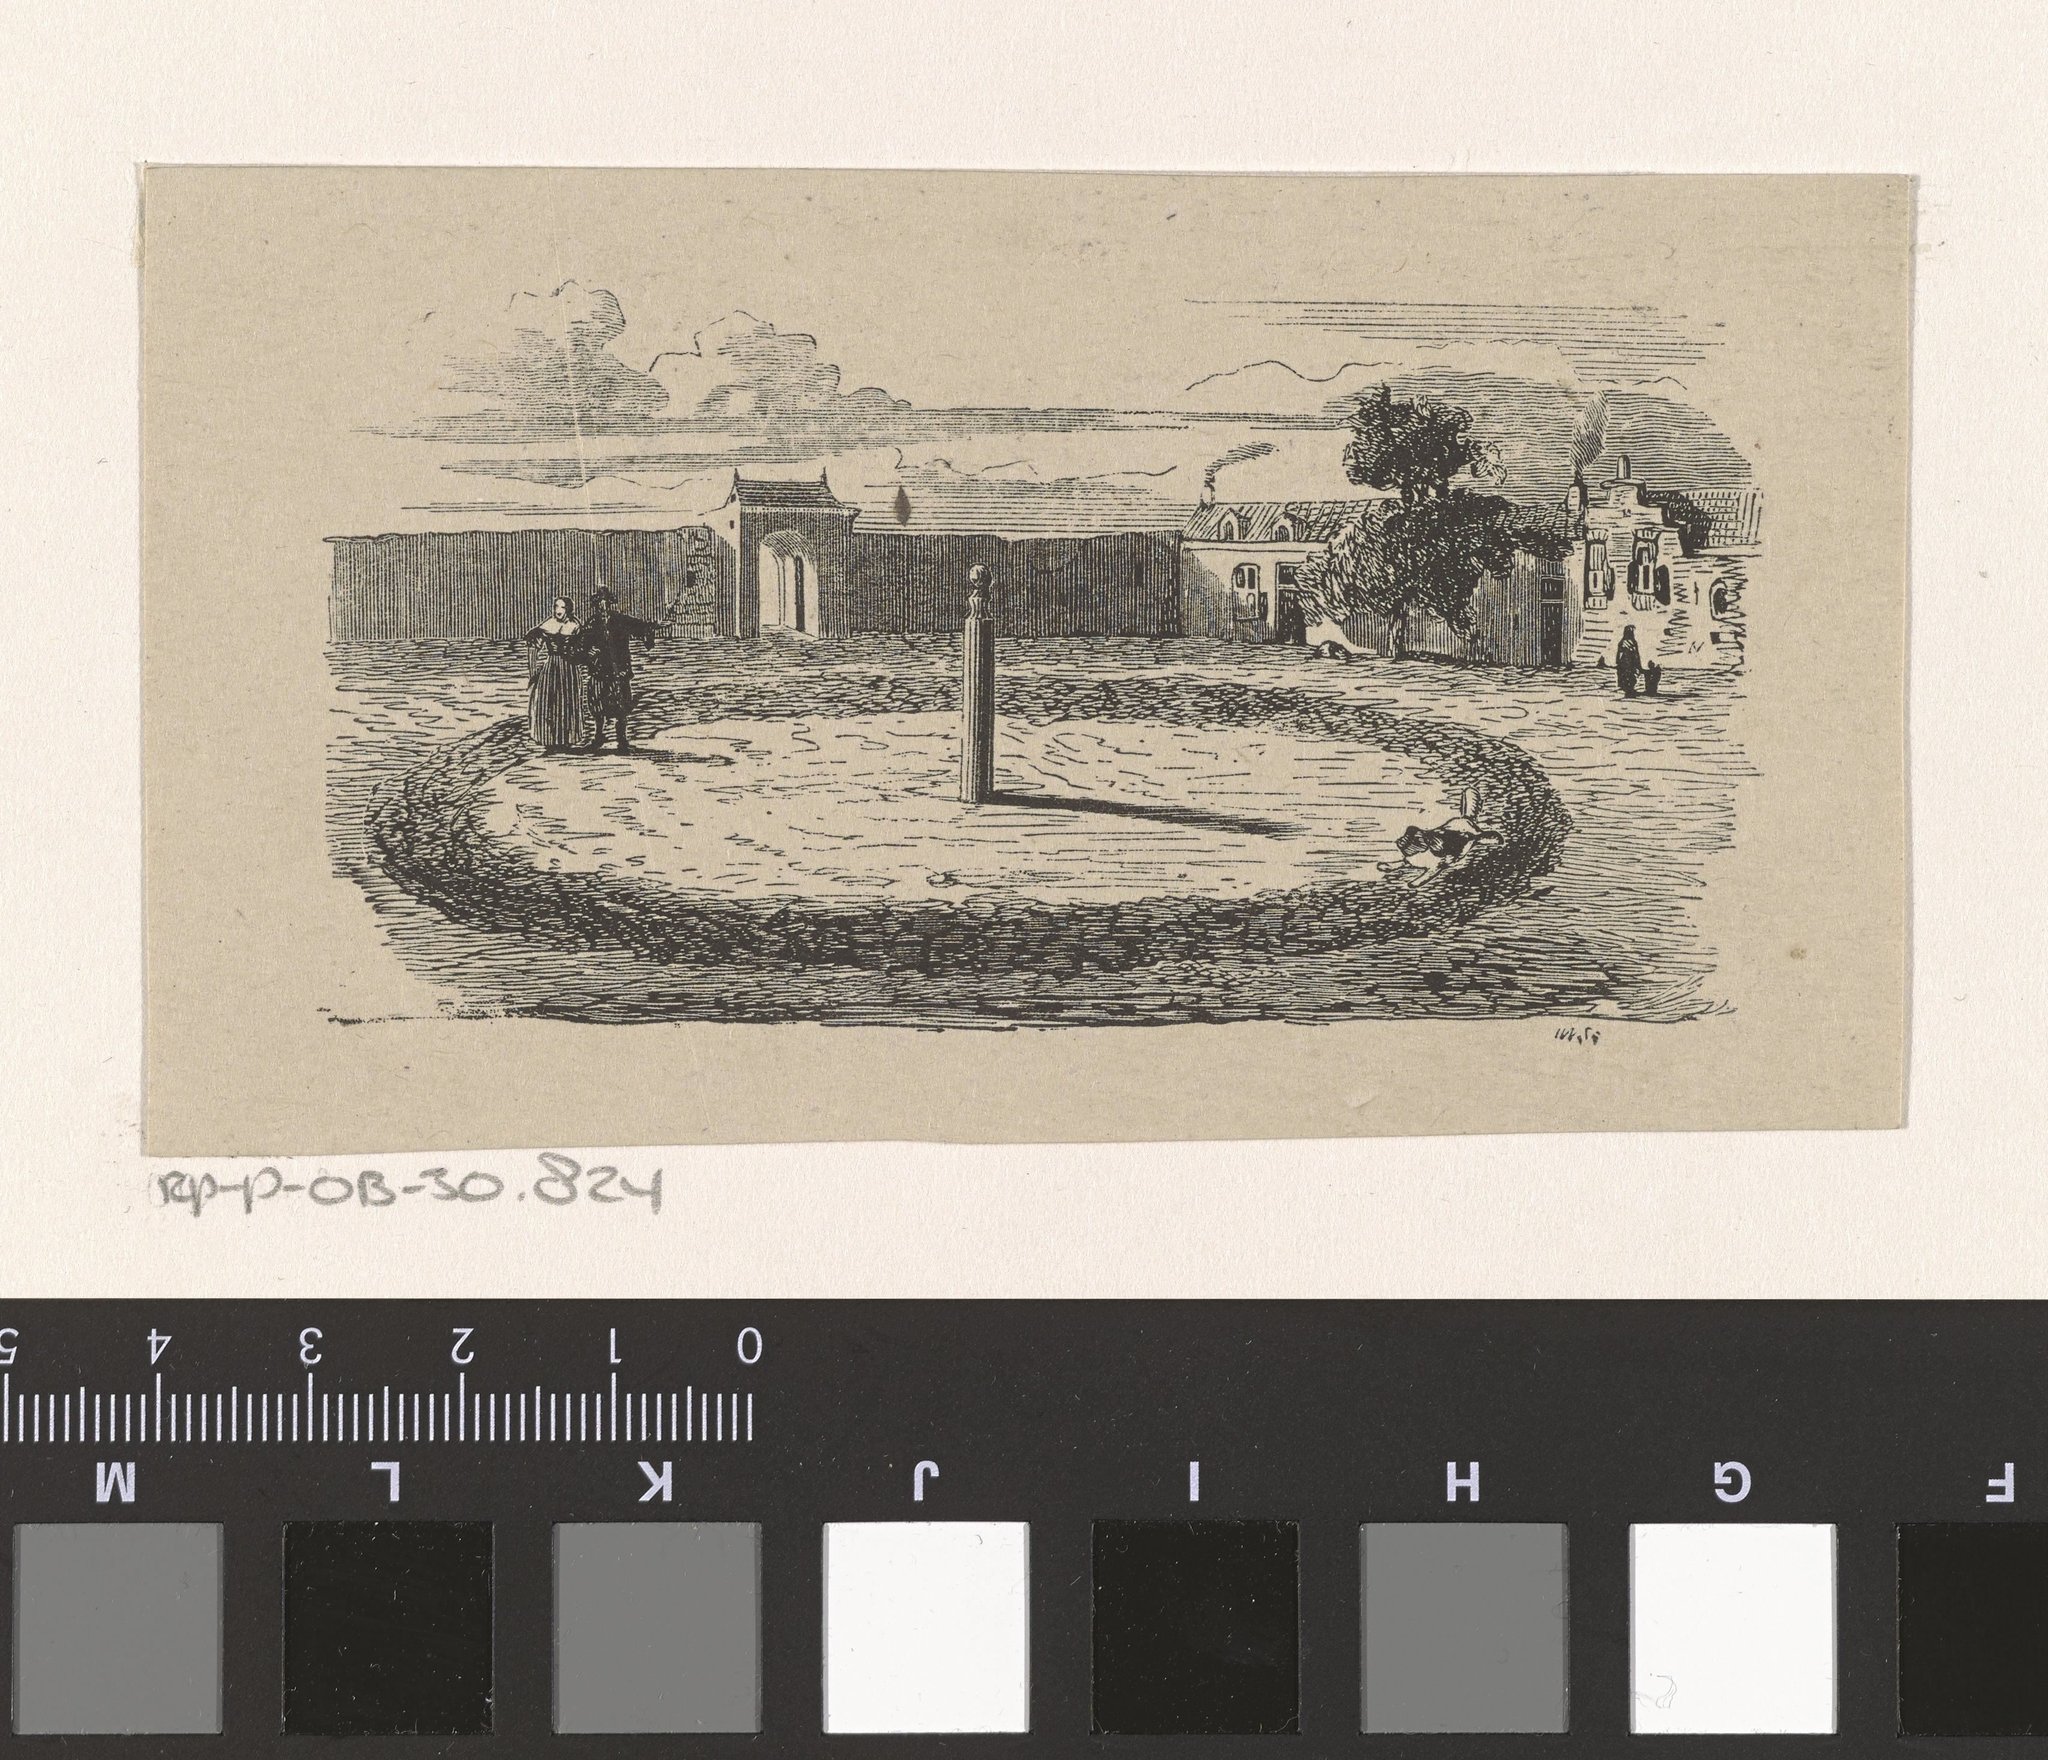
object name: print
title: Binnenplein met een hond om een paal heen rennend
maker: isaac weissenbruch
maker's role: print maker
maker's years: 1826-1912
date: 1836-1912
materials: paper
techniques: engraving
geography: netherlands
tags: standing figure, courtyard, dog